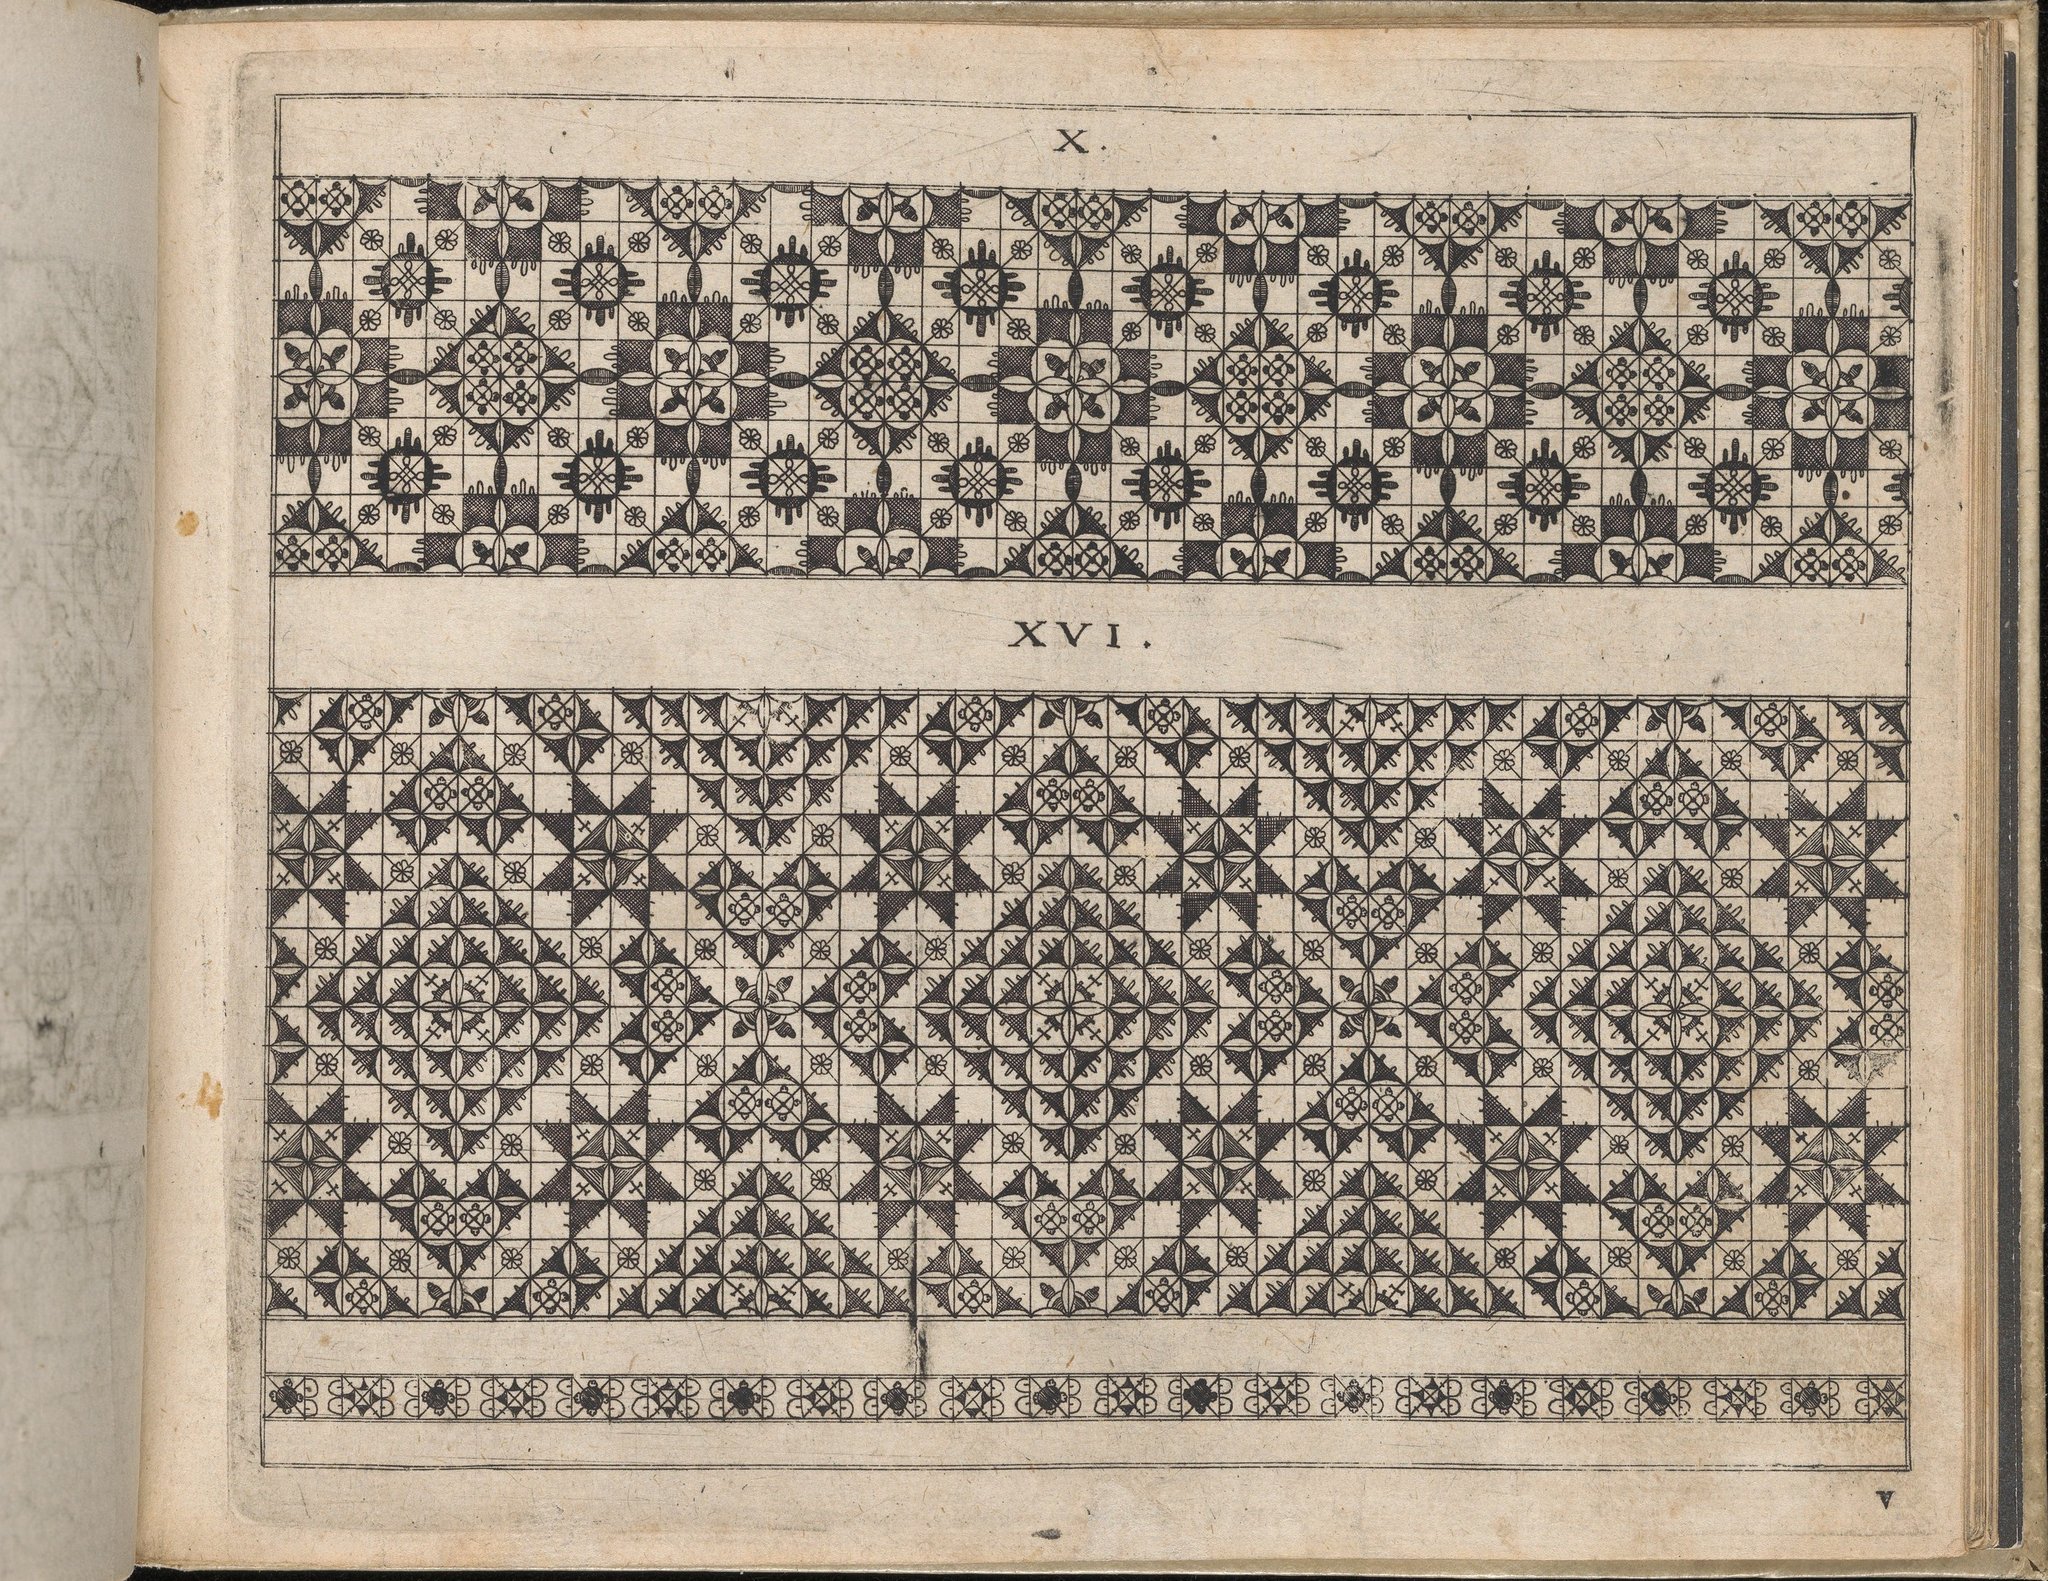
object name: book print ornament architecture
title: Newes Modelbuch in Kupffer (Page 47r)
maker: johann sibmacher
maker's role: artist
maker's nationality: german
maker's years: 1590-1611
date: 1604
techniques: etching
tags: flowers